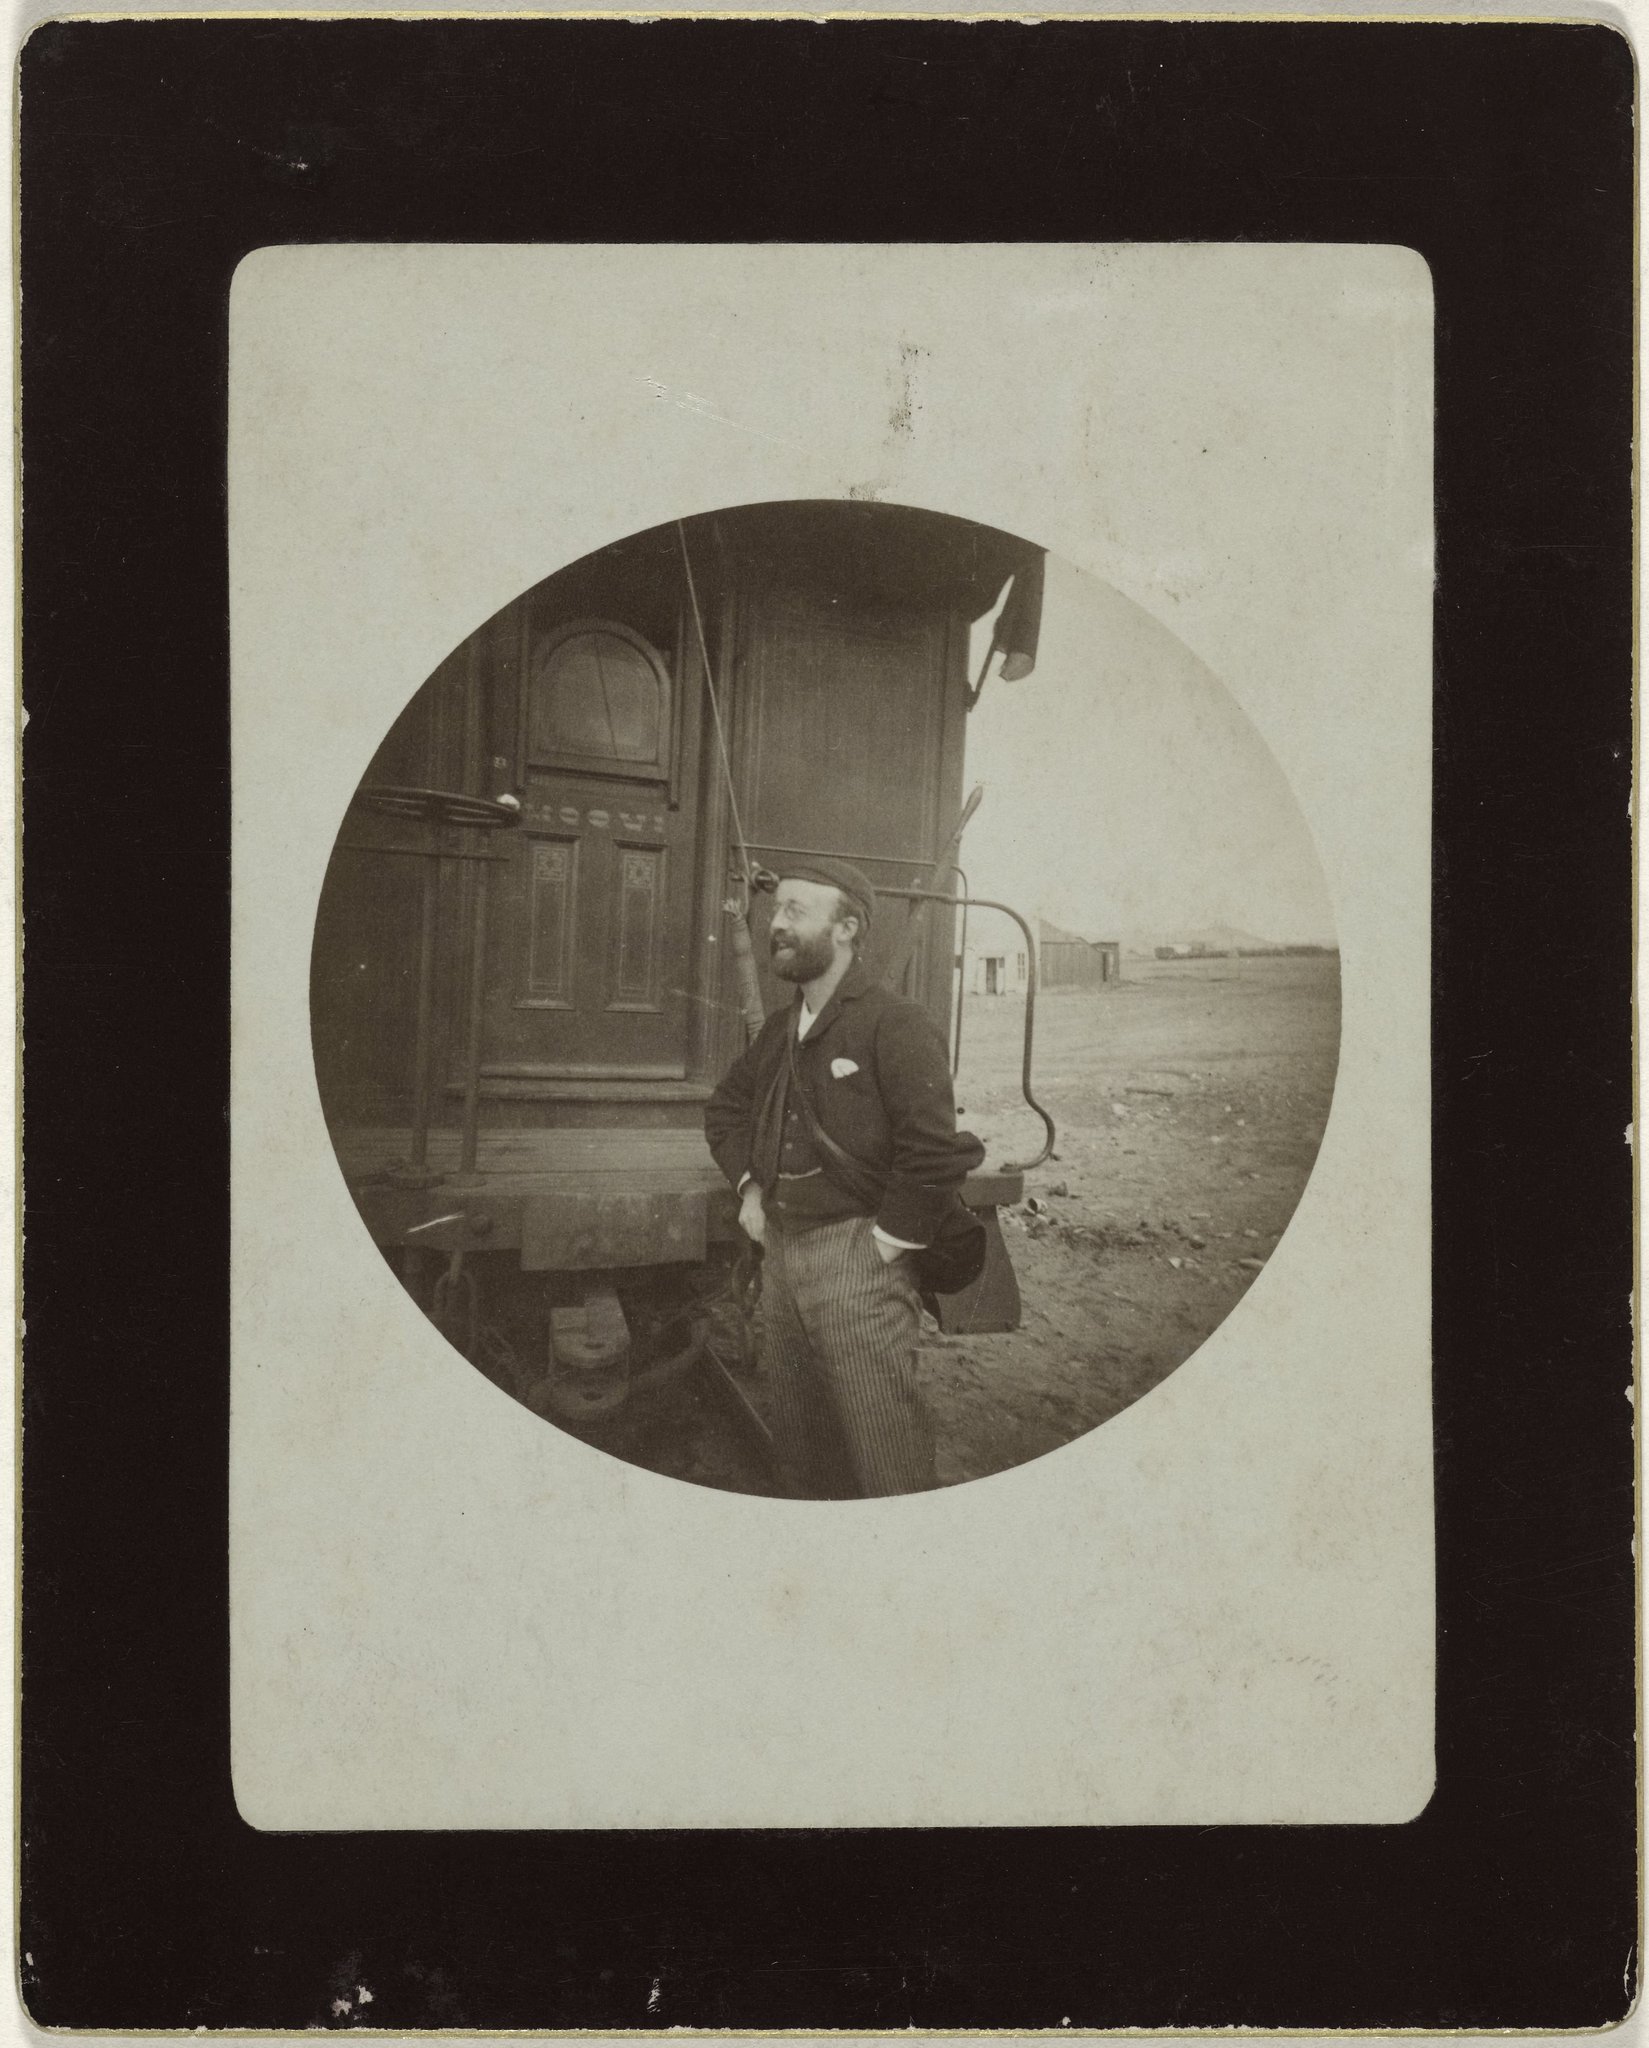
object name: photograph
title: Man bij een treinwagon van de Pullman Company in de Rocky Mountains in Colorado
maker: Anonymous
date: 1888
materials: cardboard, paper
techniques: albumen print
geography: rocky mountains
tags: railway wagon, adult man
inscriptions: inscription: ‘1888’, inscription: ‘MANUFACTURERS OF THE/ KODAK/ CAMERA/ THE EASTMAN COMPANY/ 115 OXFORD-ST/ LONDON/ ROCHESTER NY’, inscription: ‘"You stupid ass"/ H.B. Rocquet Esq/ Rear of Pullman Car/ "See you"/ [...]’